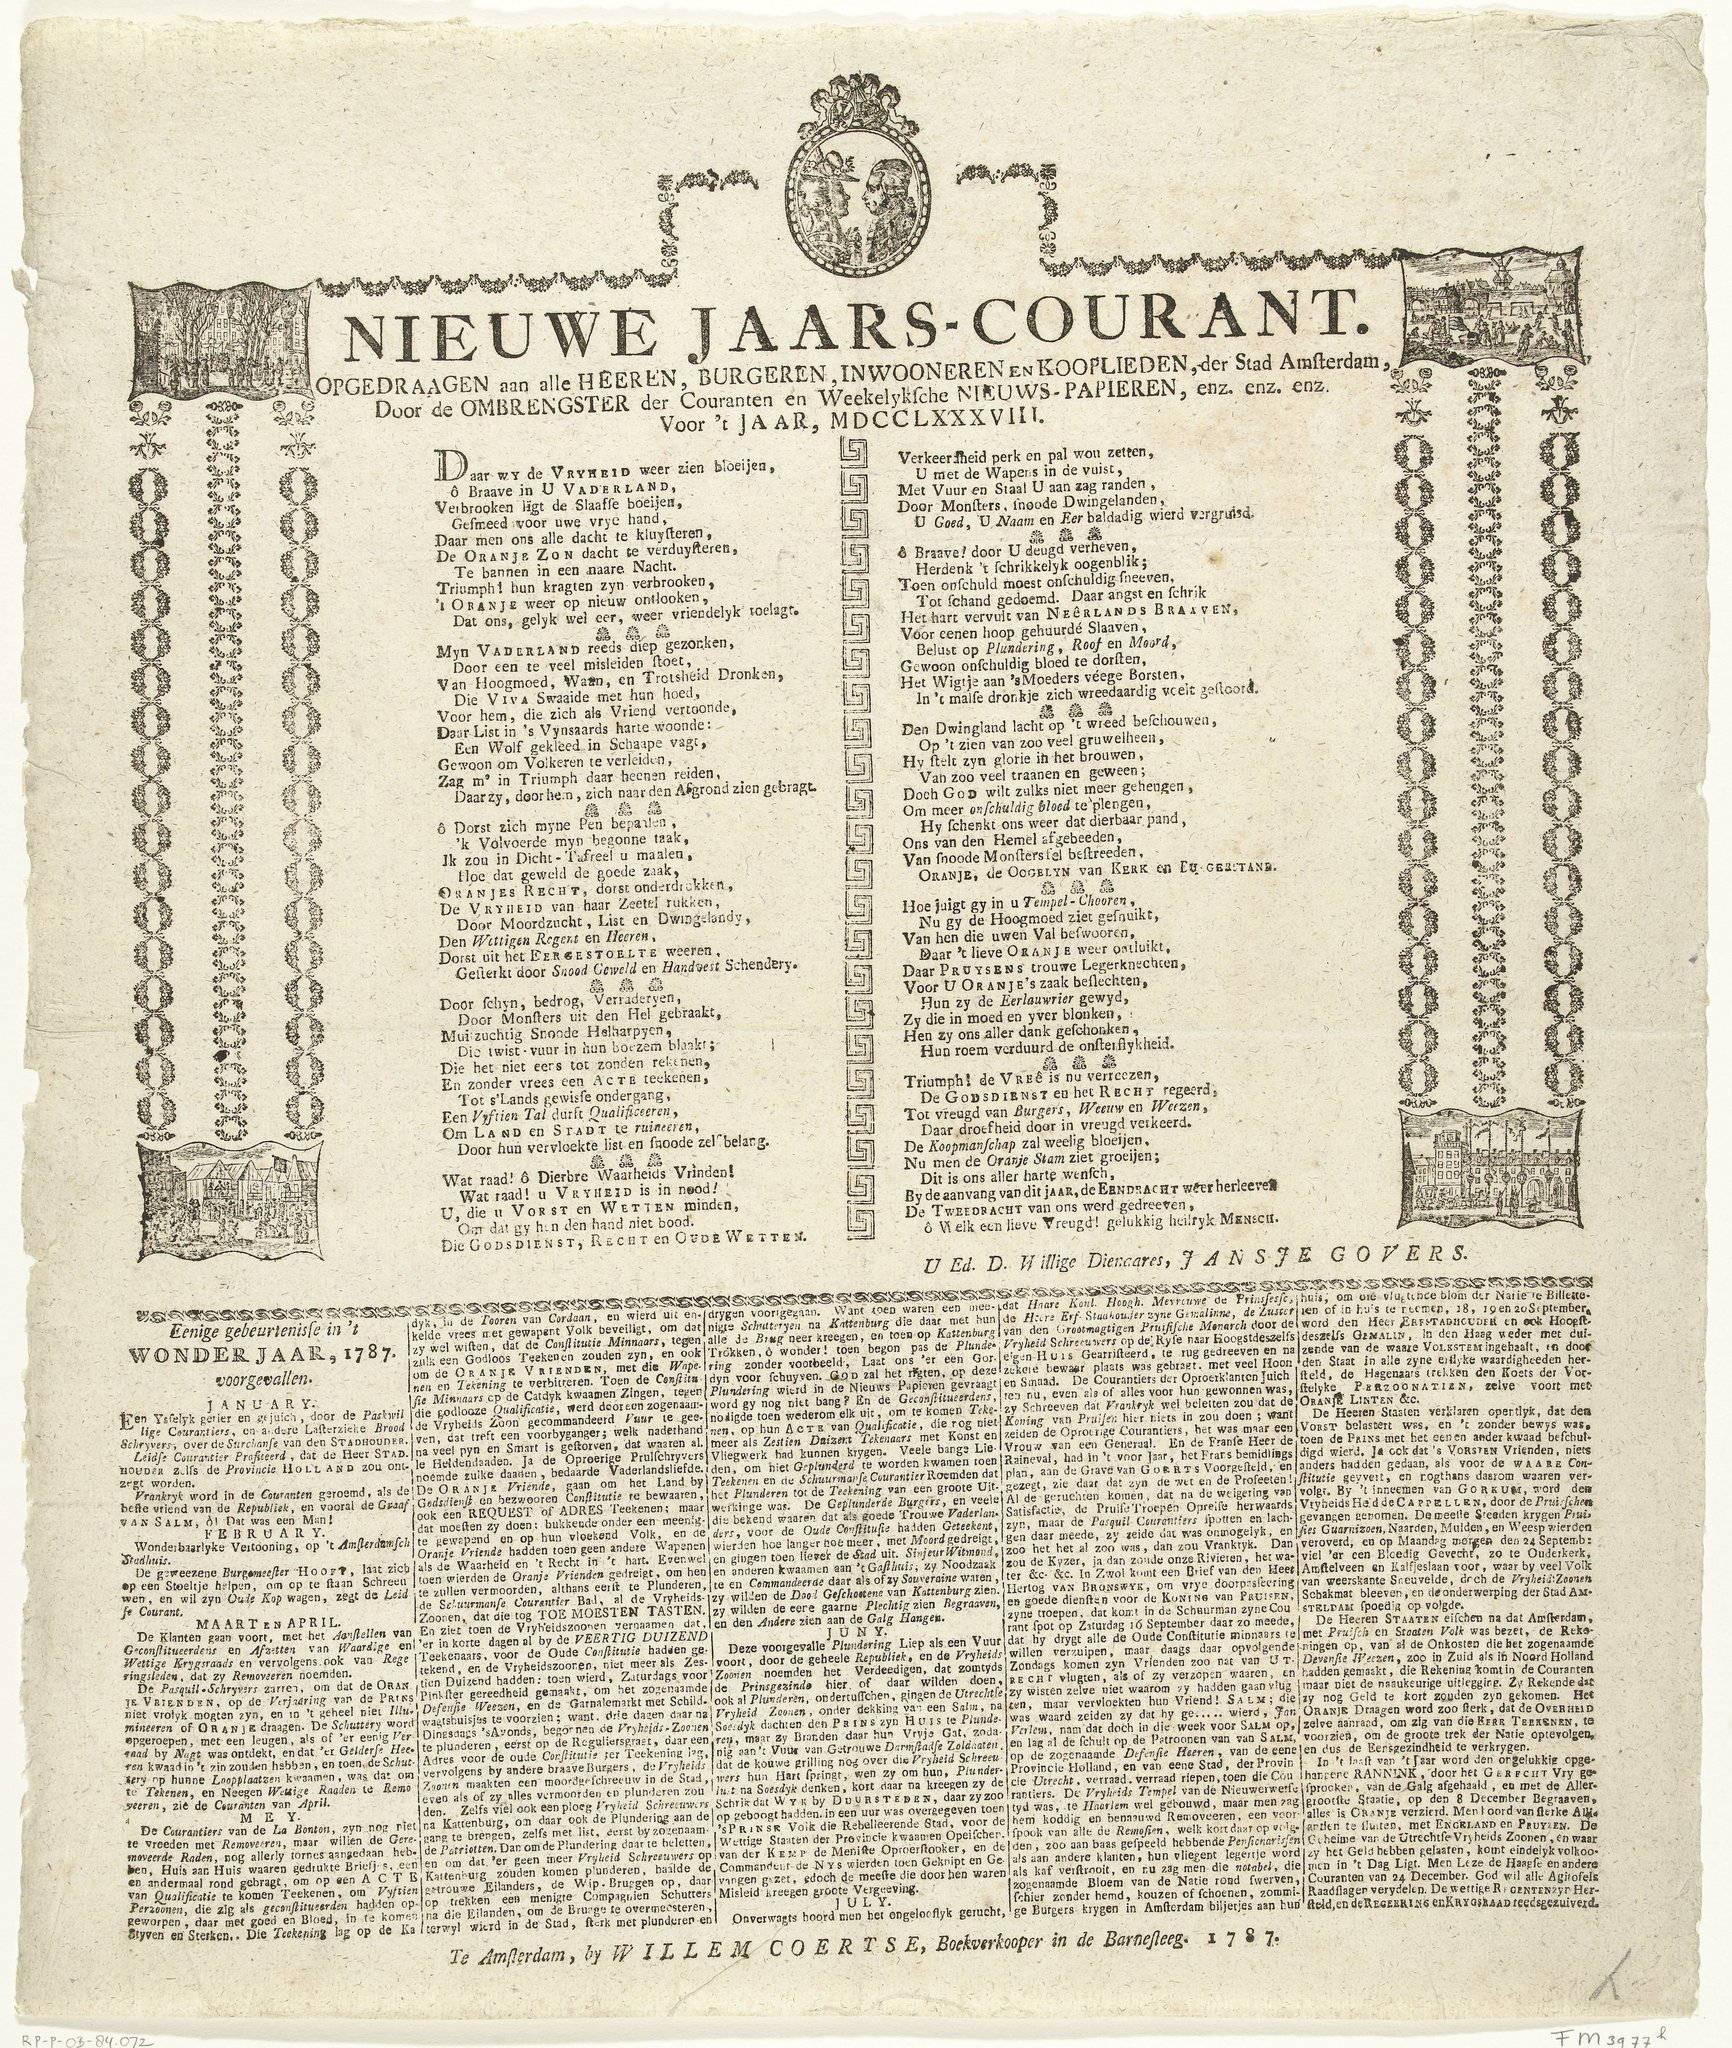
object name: new year card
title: Nieuwe Jaars-Courant. Opgedraagen aan alle Heeren, Burgeren, Inwooneren en Kooplieden, der Stad Amsterdam, Door de Ombrengster der Couranten en Weekelyksche Nieuws-Papieren, enz. enz. enz. Voor 't Jaar, MDCCLXXXVIII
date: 1787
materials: paper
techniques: letterpress printing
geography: amsterdam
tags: the hague, william v (prince of orange), berlin, painter, draughtsman, wilhelmina of prussia (princess of orange)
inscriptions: collector's mark: Lugt 2228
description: Nieuwjaarsprent van de Amsterdamse courantbezorgster Jansje Govers voor het jaar 1788, opgedragen aan de burgers van Amsterdam. Bovenaan een klein vignet met portretten van prins Willem V met gemalin en op het blad een vers in twee kolommen versierd met randen en vier kleine voorstellingen met stadsgezichten in de hoeken. Onderaan in vijf kolommen een overzicht van de belangrijkste gebeurtenissen uit het afgelopen jaar.